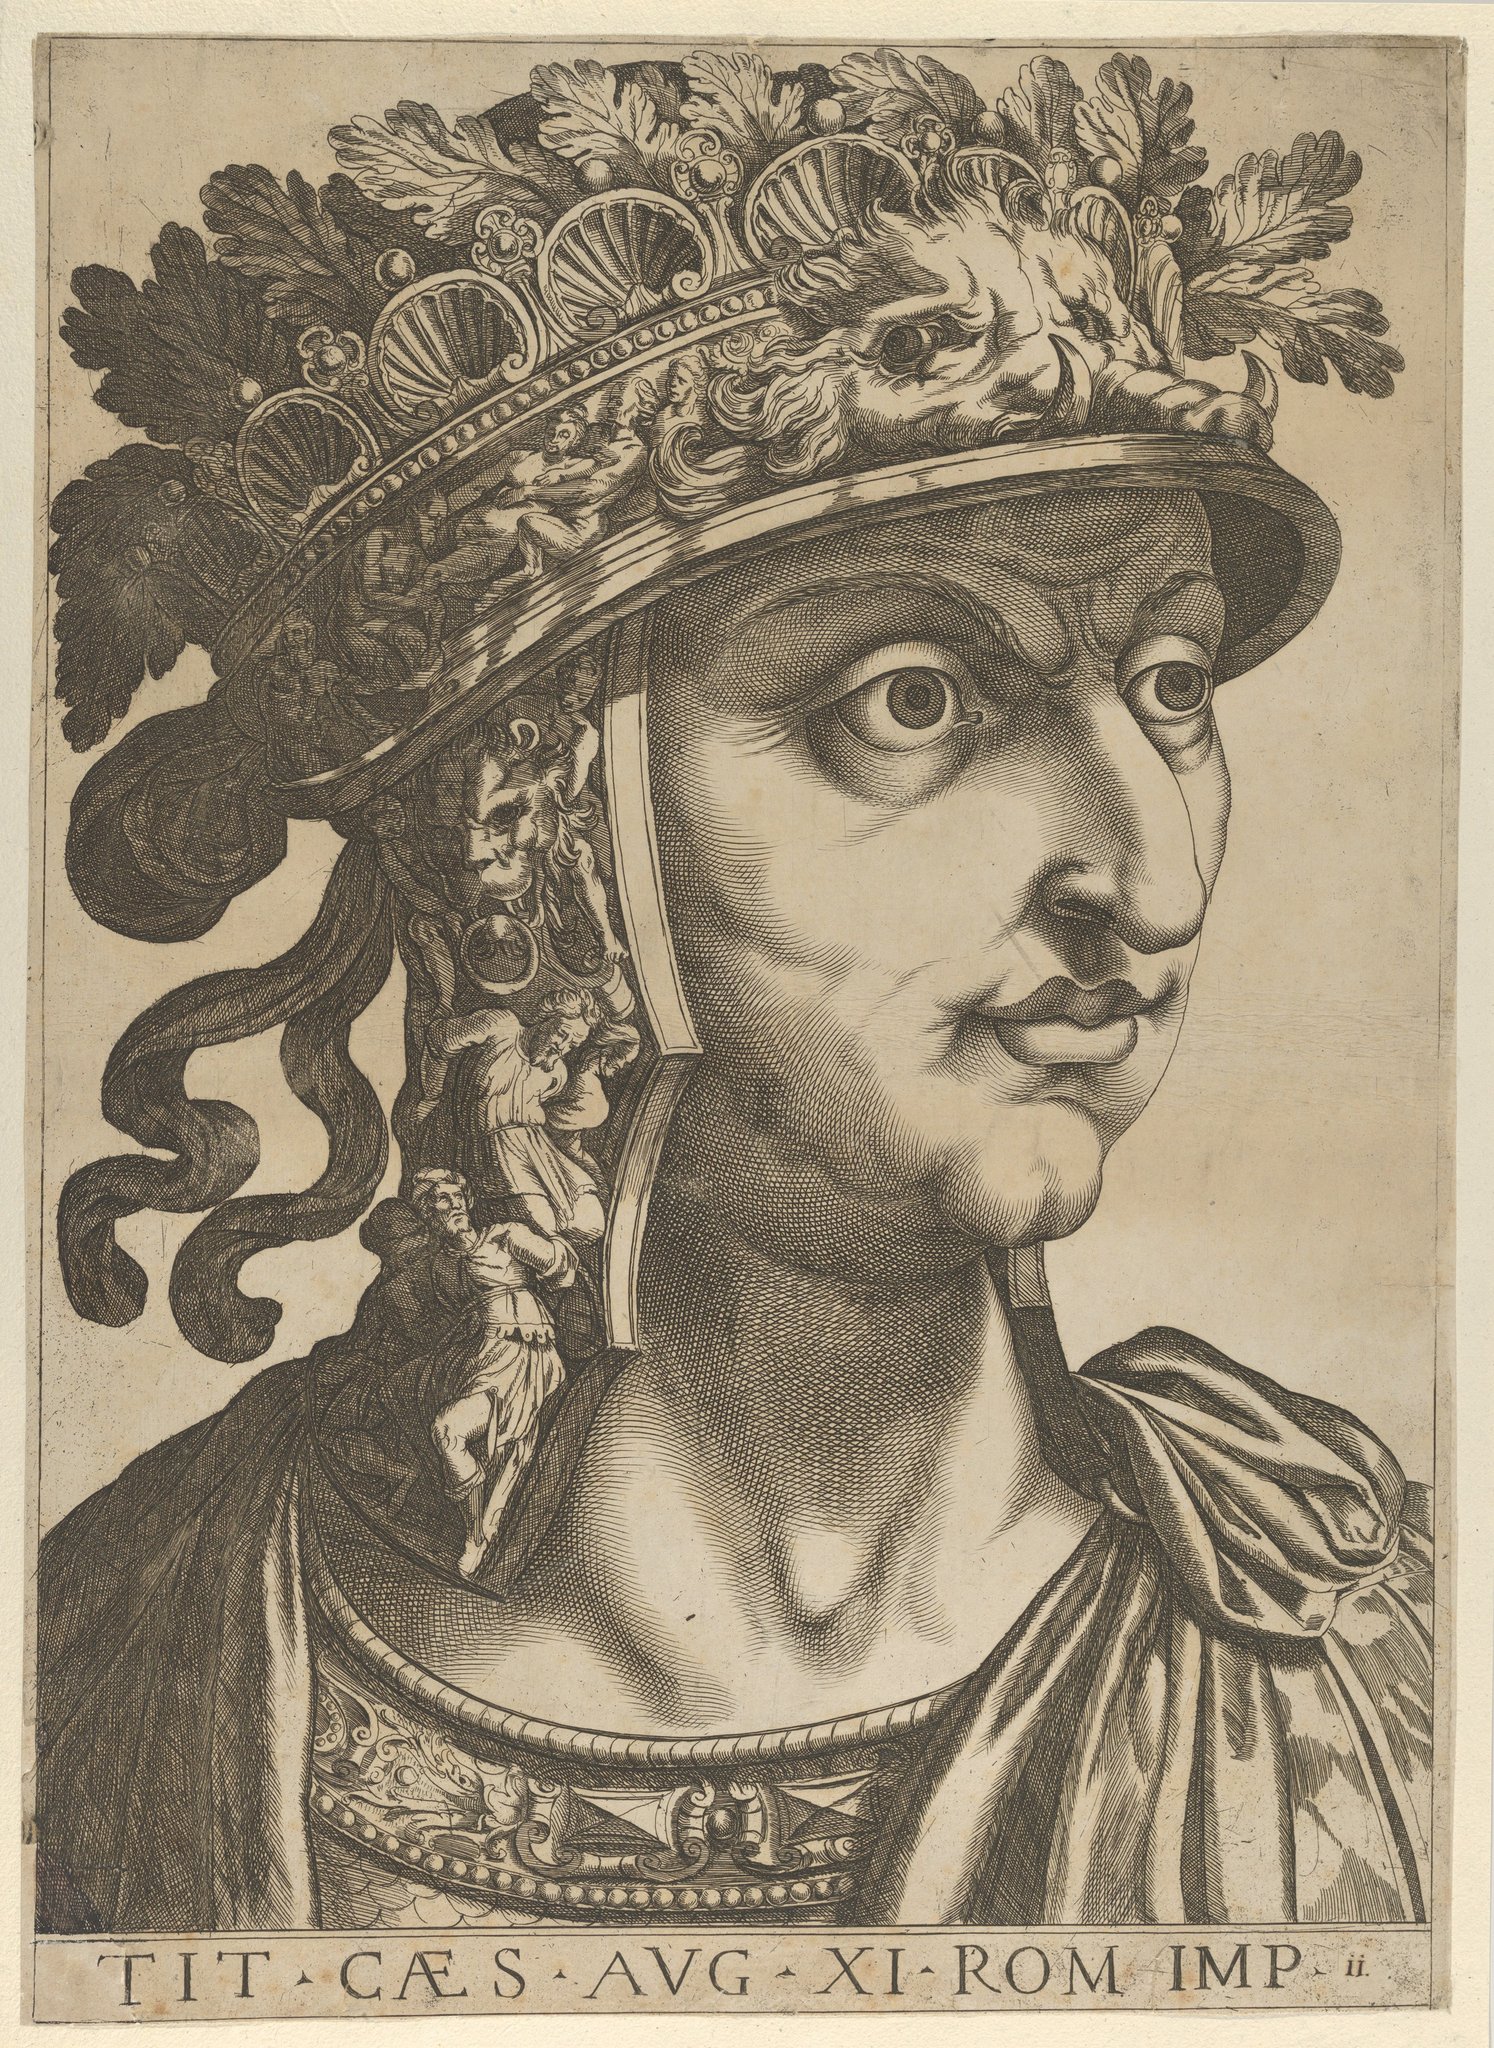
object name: print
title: Plate 11: Titus Vespasian looking to the right, from "The Twelve Caesars"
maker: Anonymous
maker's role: artist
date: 1610-1640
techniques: engraving, etching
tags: men,portraits